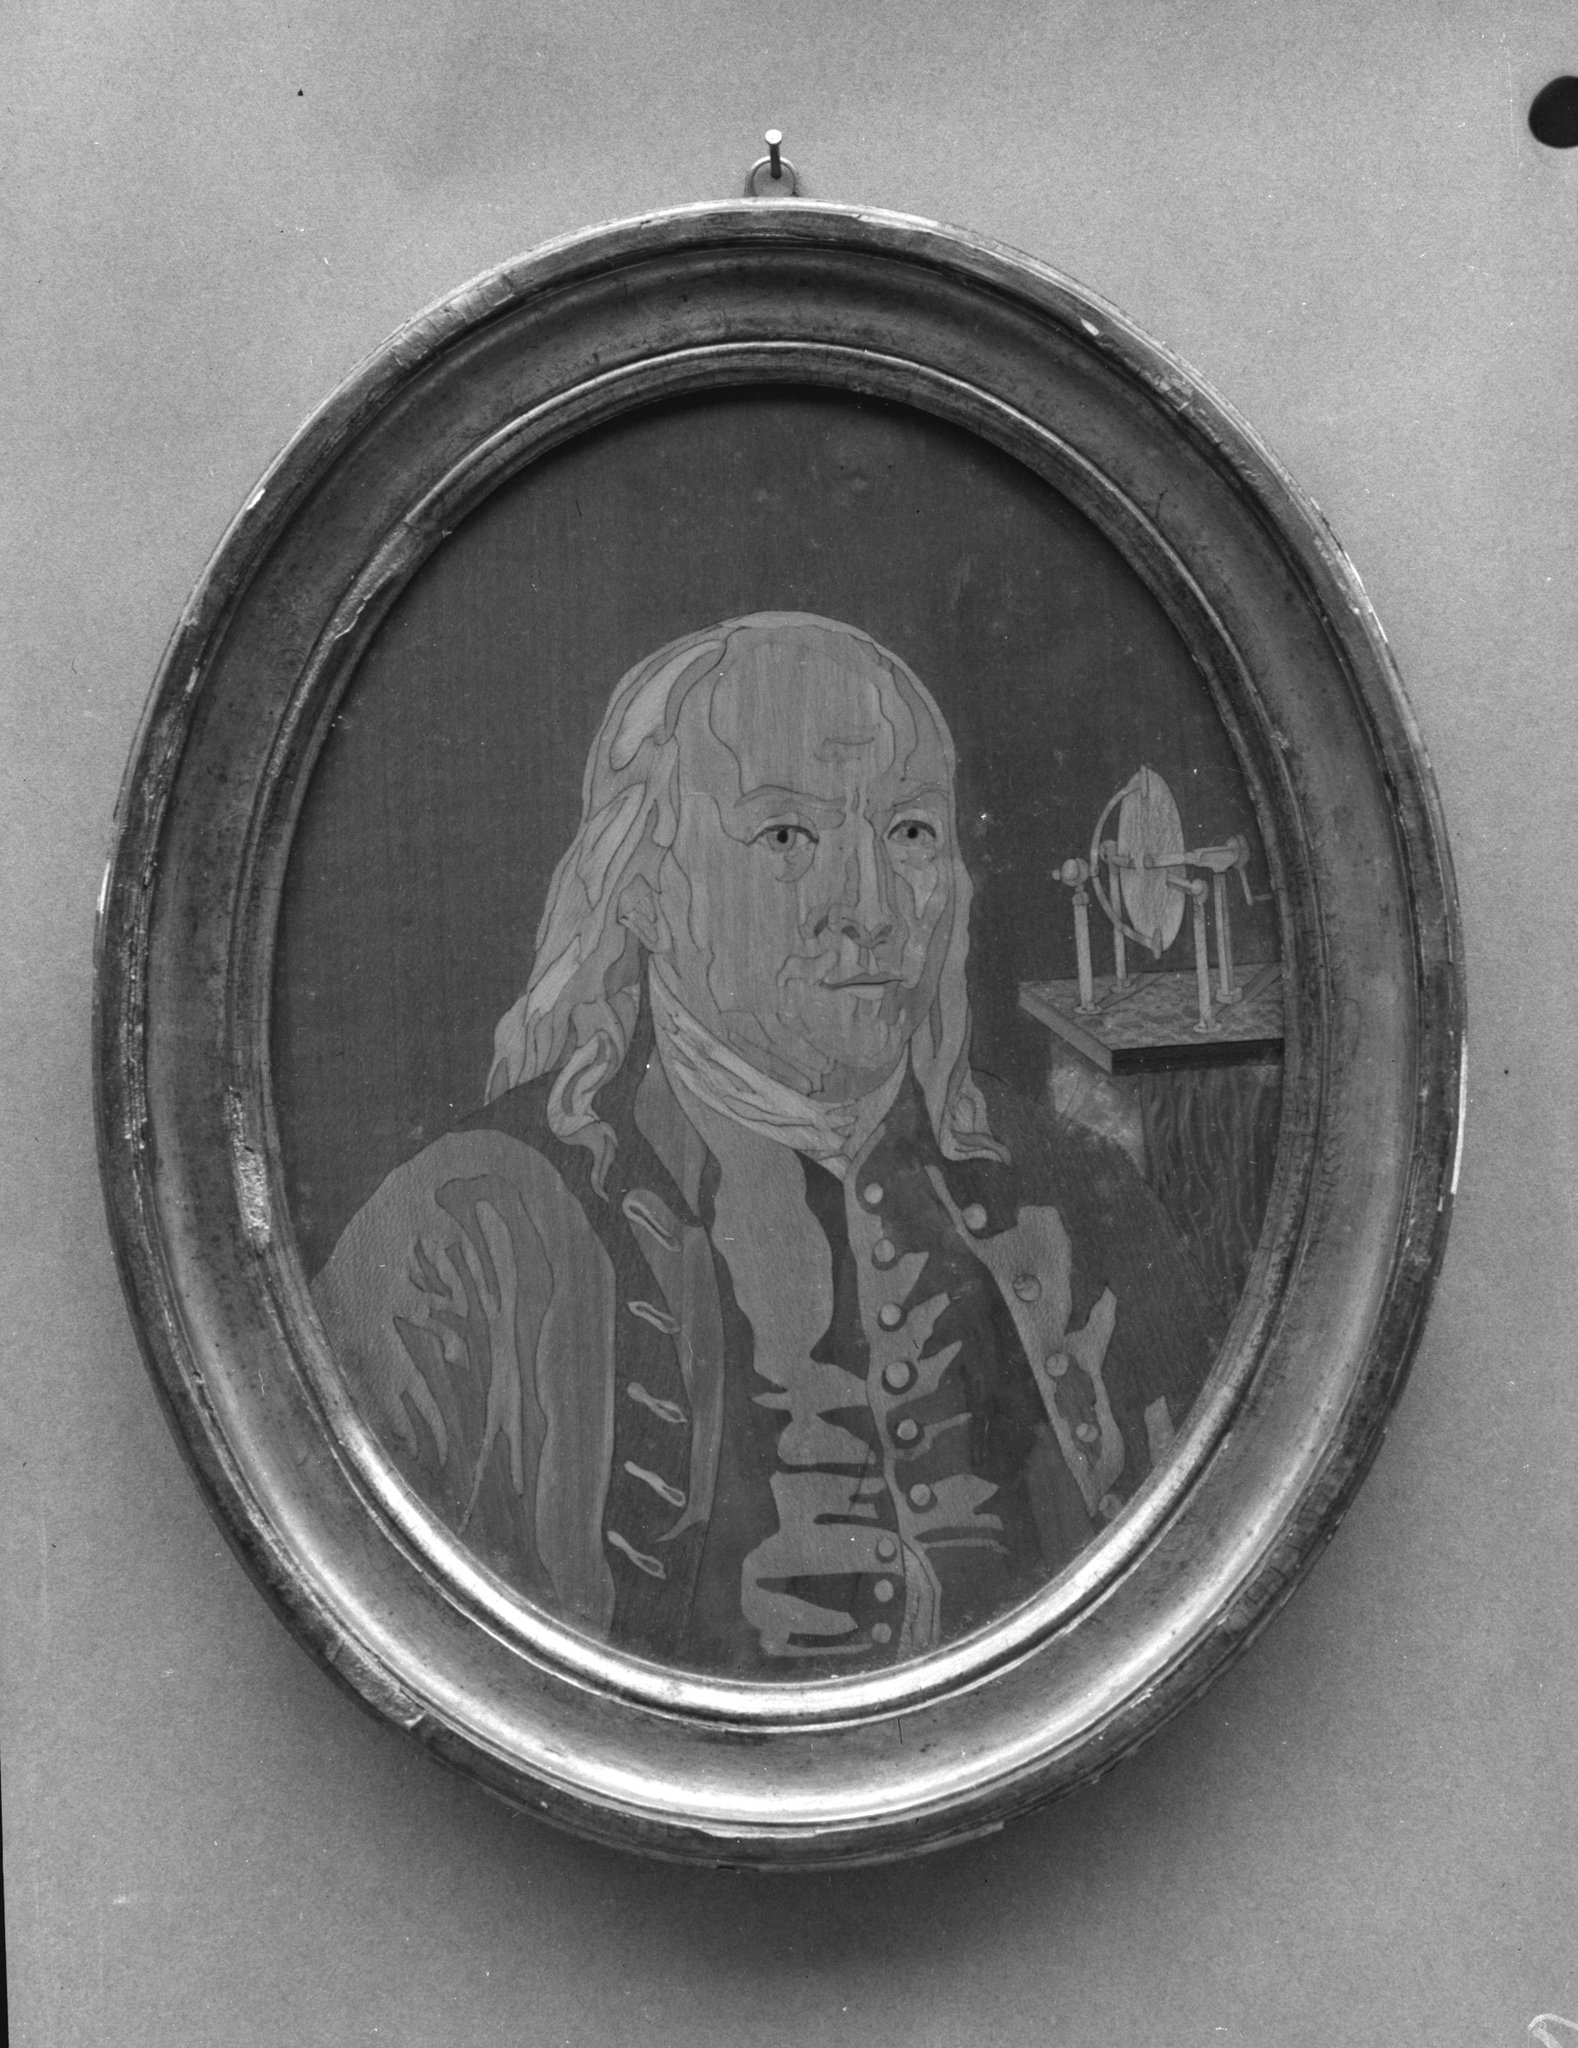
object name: portrait panel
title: Portrait Panel of Benjamin Franklin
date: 1780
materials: wood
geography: germany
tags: benjamin franklin,portraits